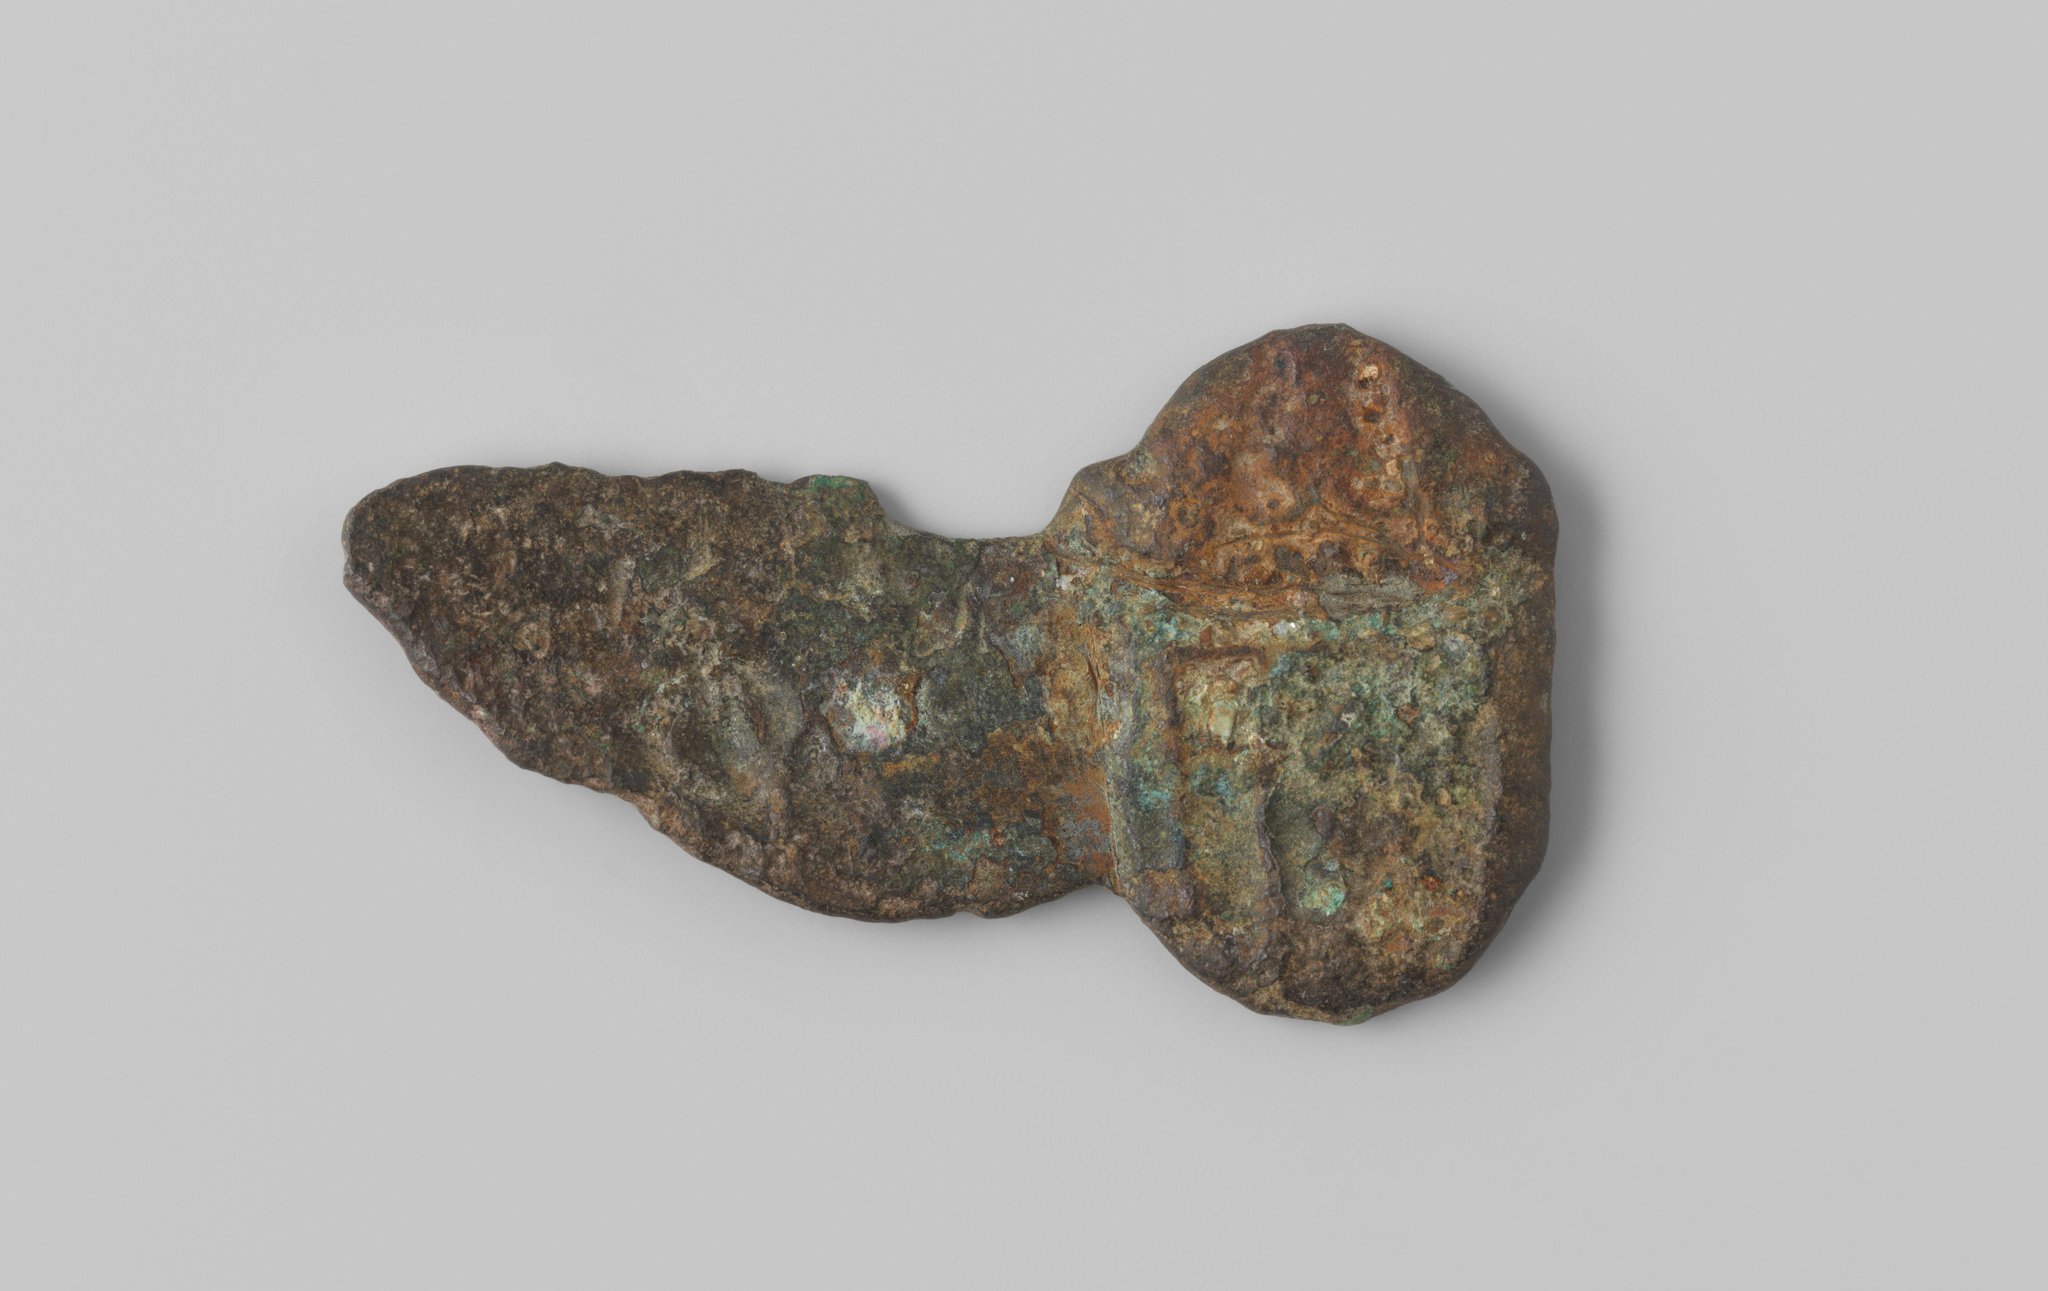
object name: schroefplaat, schroefblik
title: Fragment schroefplaat van een musket uit het wrak van de Oost-Indiëvaarder Hollandia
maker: Anonymous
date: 1700-1743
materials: copper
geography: netherlands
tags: verenigde oostindische compagnie, hollandia (schip), annet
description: Fragm, id. NG 1980-27H3069, right wing broken off, side plate.